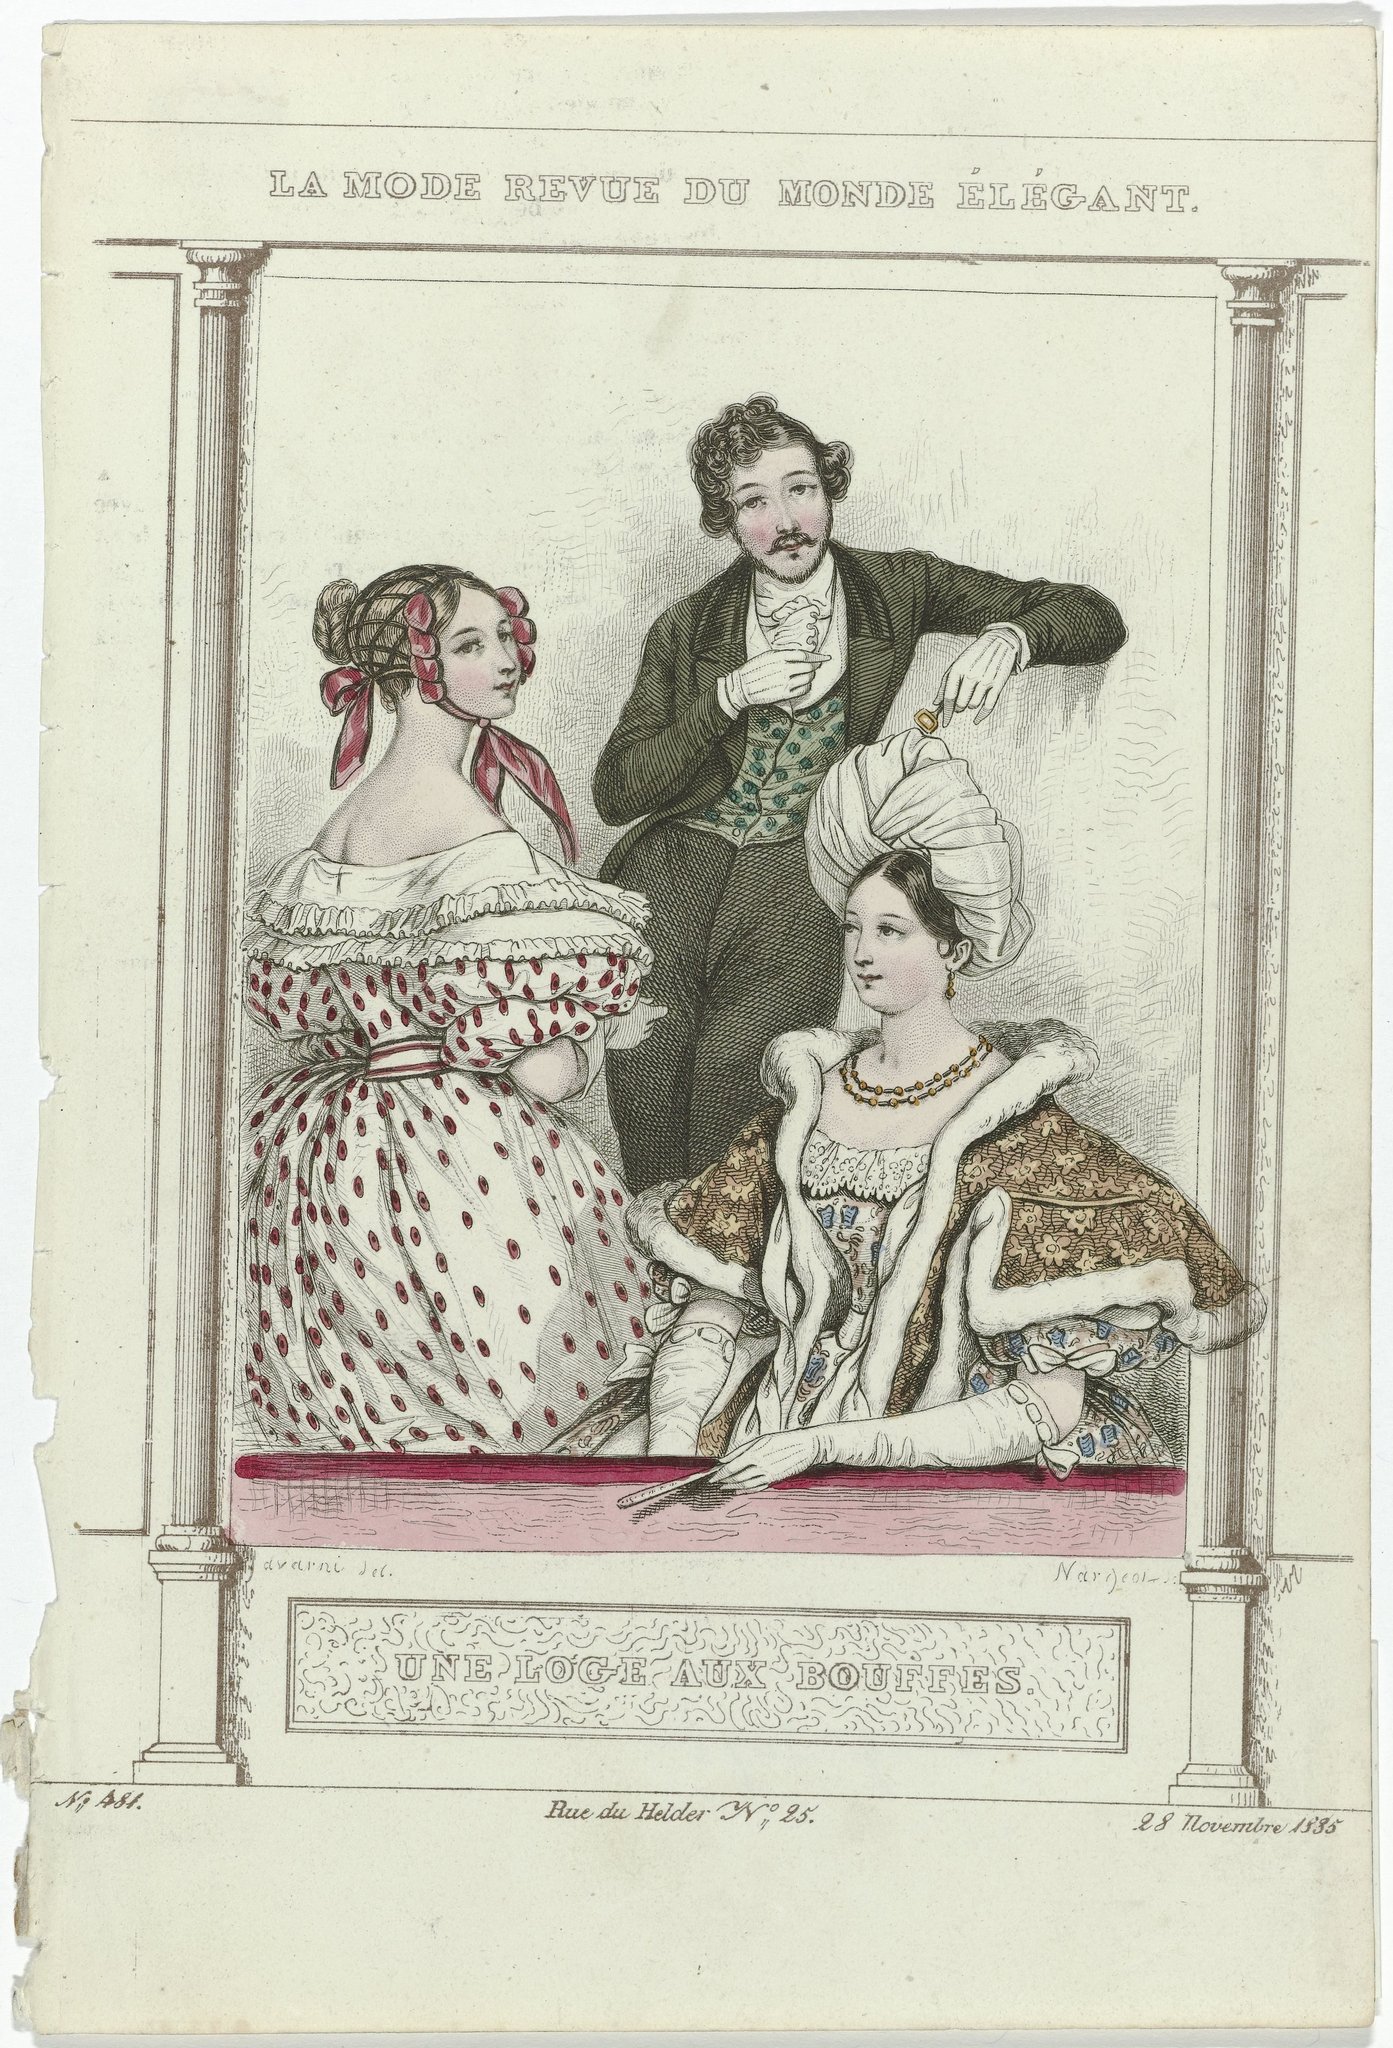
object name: fashion print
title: La Mode, 28 novembre 1835, Pl.481 : La mode revue du monde élégant (...)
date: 1835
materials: paper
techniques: engraving, etching, hand coloring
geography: paris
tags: clothing for the upper part of the body (vest) (+ men's clothes), clothing for the upper part of the body (+ women's clothes), ear-rings (+ women's clothes), head-gear: turban (+ women's clothes), gloves, mittens (long gloves) (+ women's clothes), neck-gear ~ clothing (+ men's clothes), monocle, single lorgnette (+ male human being (not to be used where -a- is prescribed)), trousers, breeches, etc. (pantalon) (+ men's clothes), boxes, loges ~ theatre, etc., coat (+ men's clothes), styles of hairdress - aa - ~ women, fashion plates, dress, gown (+ women's clothes), fan (+ women's clothes), gloves, mittens, etc. (+ men's clothes), necklace (+ women's clothes)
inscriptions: caption: ‘Une loge aux bouffes.’, address: ‘Rue du Helder No"25’, title: ‘La mode revue du monde élégant.’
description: Een gezelschap in een theaterloge. Vrouw in een gestippelde japon met korte mouwen. Dubbele kraag, afgezet met gerimpelde stroken stof. Haarnet met linten. Lange handschoen. Man in jas, vest en broek. Geknoopte halsdoek. Handschoenen. Lorgnet. Vrouw met tulband. Japon met korte mouwen. Schoudermantel met bloempatroon afgezet met bont. Accessoires: tulband, oorbel in het linkeroor lange handschoenen. Prent uit het modetijdschrift La Mode (1829-1855).